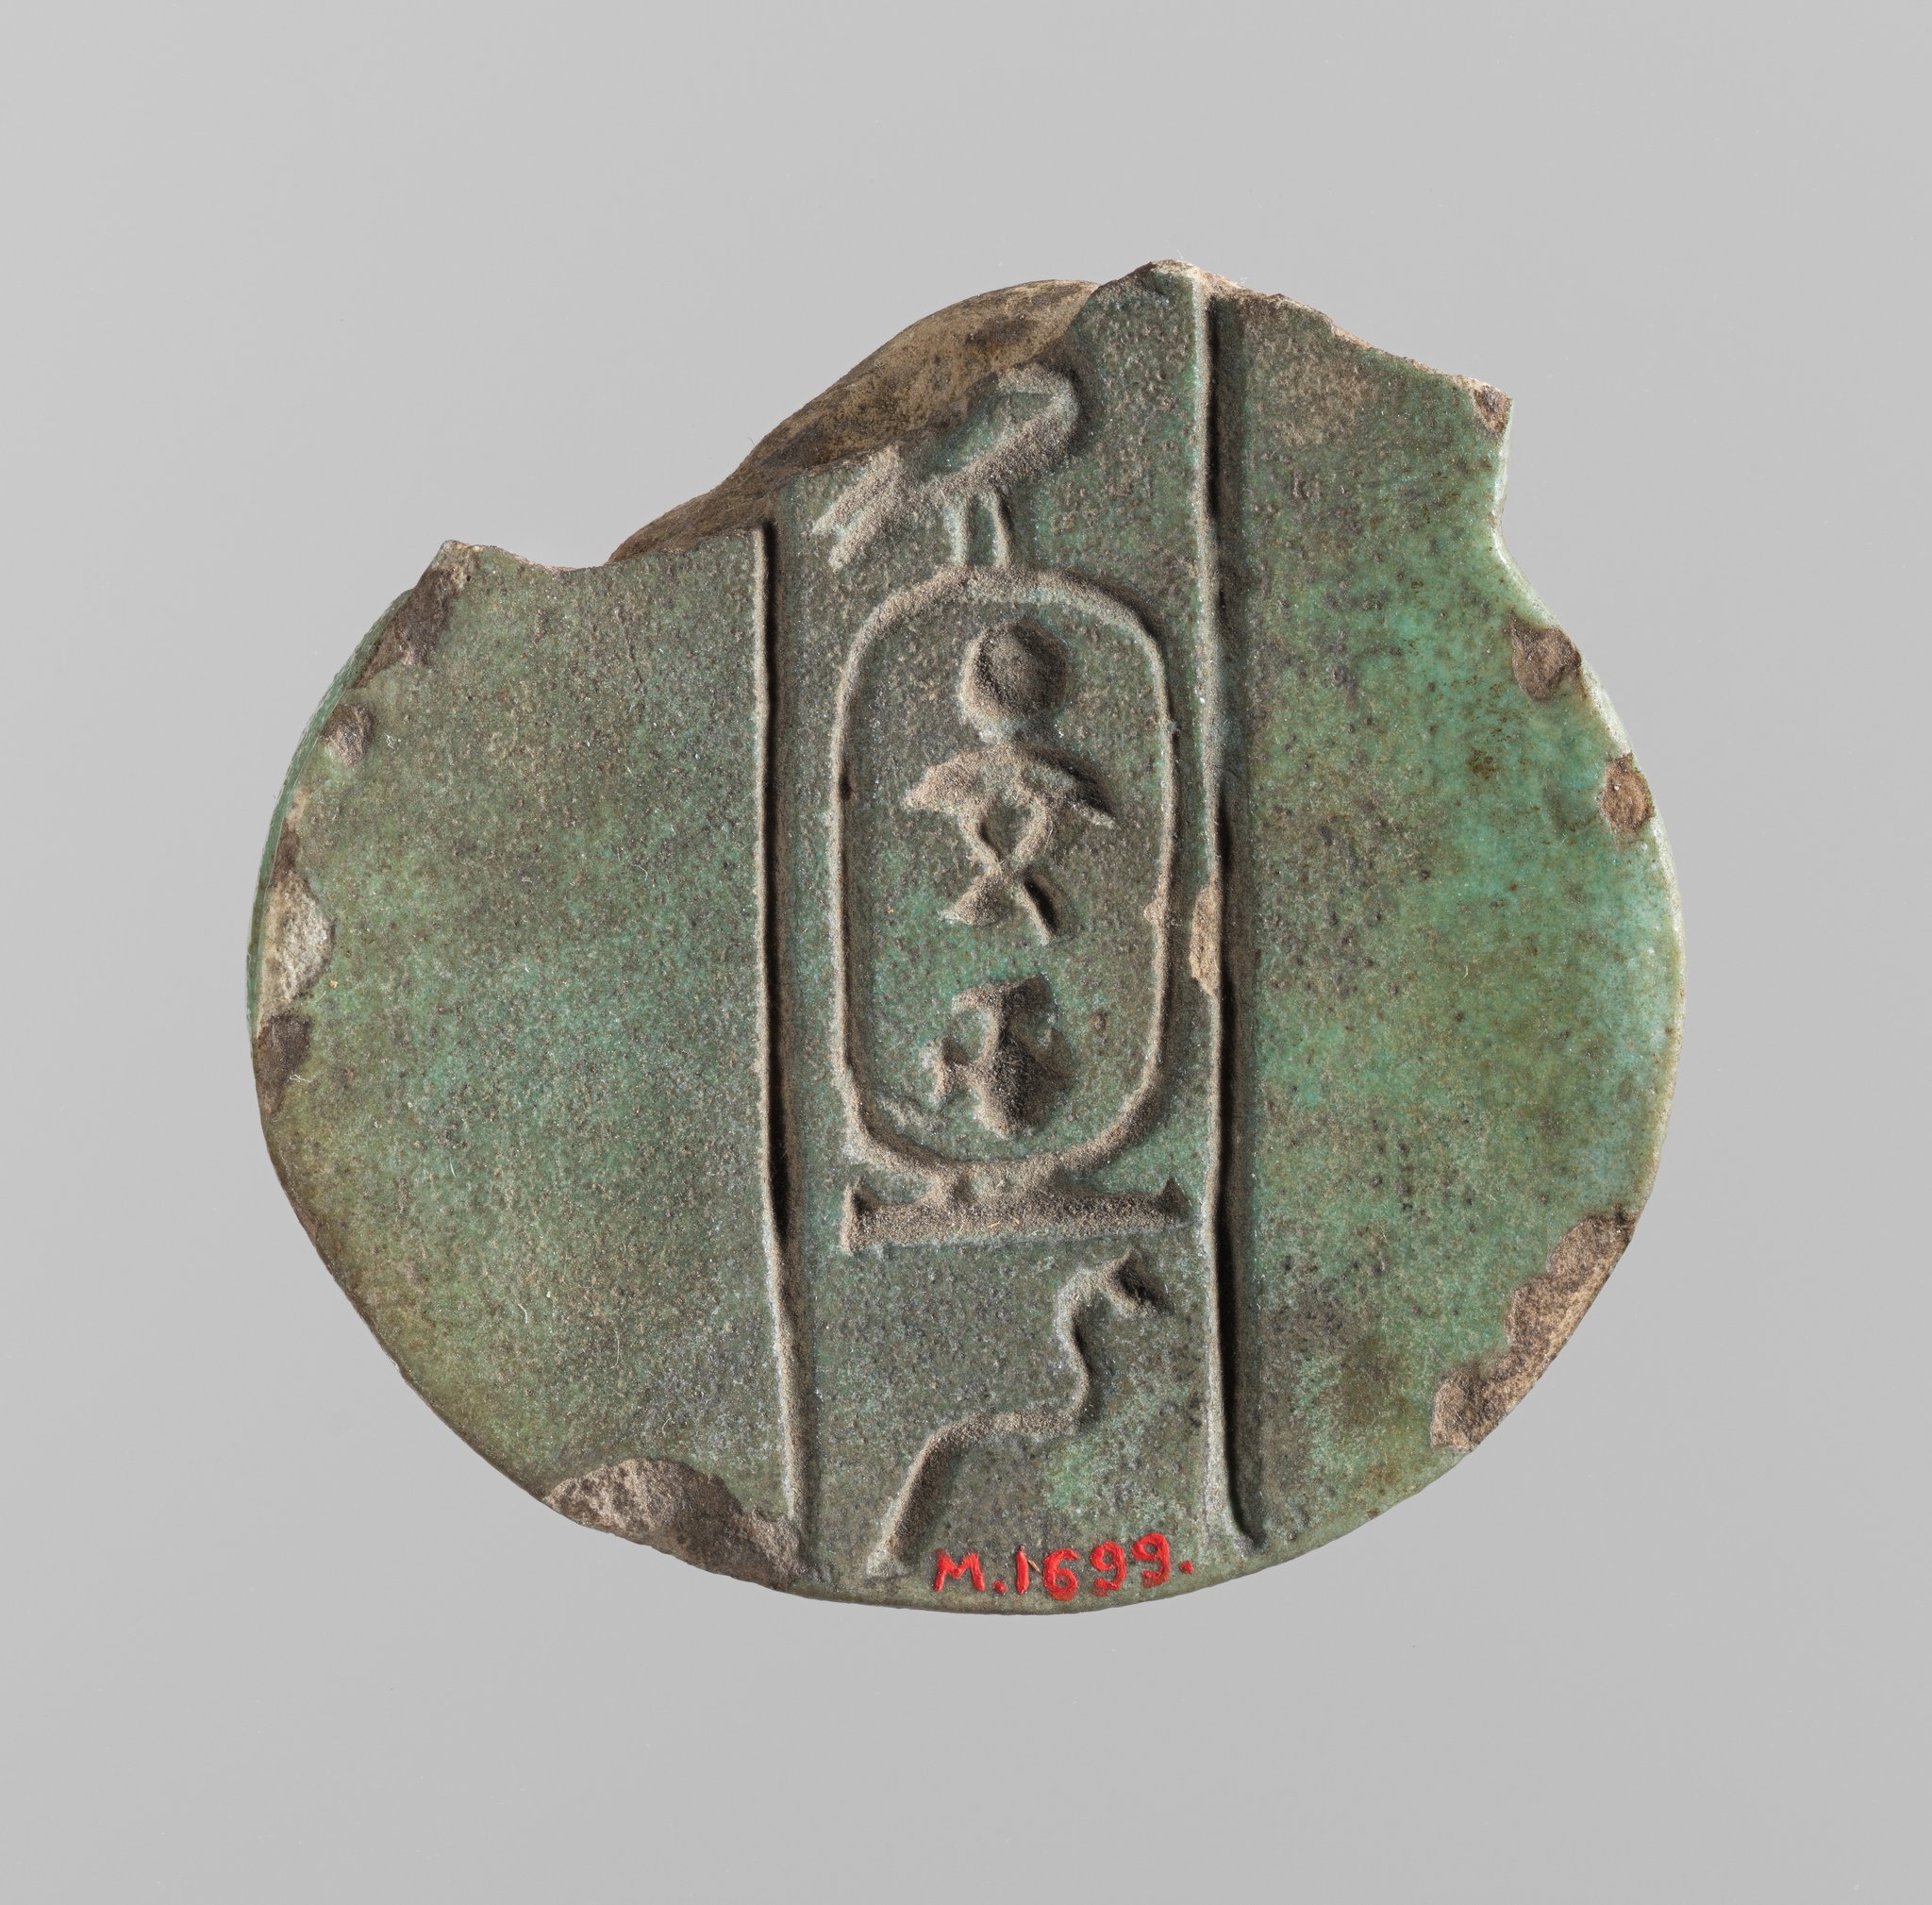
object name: menat fragment, psamtik i or apries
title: Menat fragment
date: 664-570 BCE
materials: limestone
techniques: glazing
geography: egypt